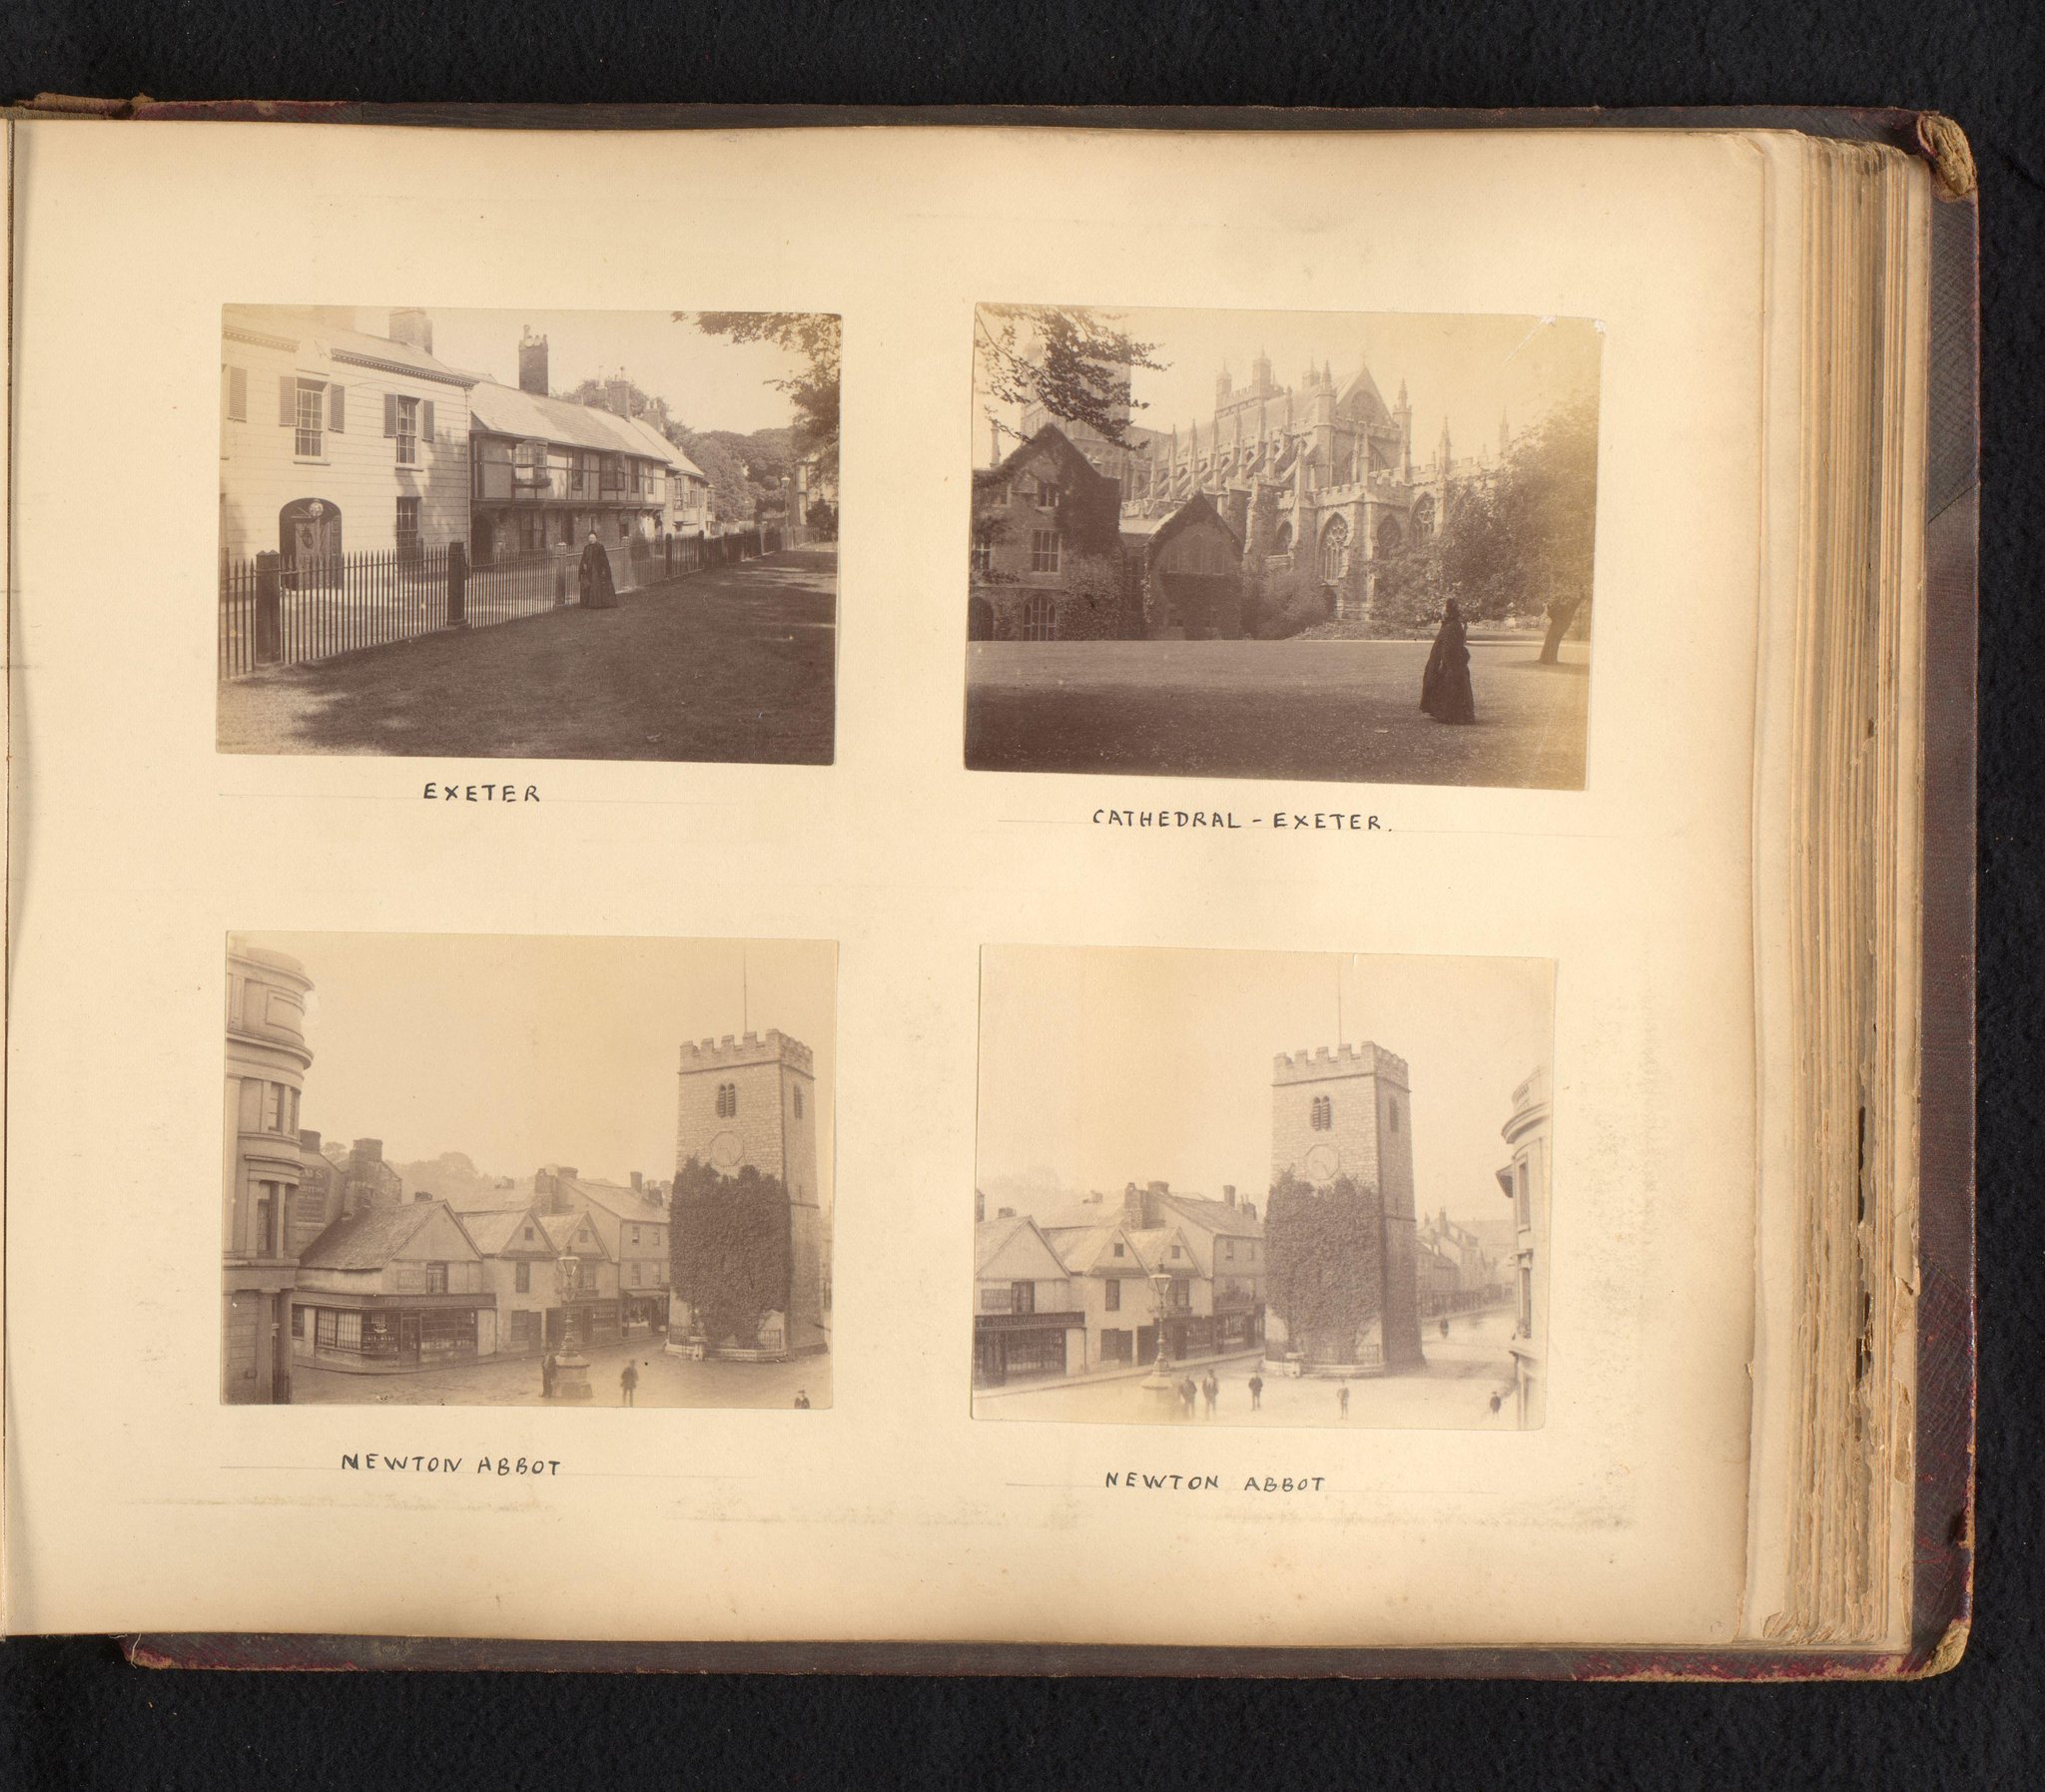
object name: photograph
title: Plekken in en Exeter en Newton Abbot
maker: Anonymous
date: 1890-1897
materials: photographic support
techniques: albumen print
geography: england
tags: market cross, church (exterior), gate, entrance, civic architecture; edifices; dwellings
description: Straatgezicht te Exeter, gezicht op de Kathedraal van Exeter en twee gezichten op St Leonard's Tower te Newton Abbot. Deze pagina maakt deel uit van een album.